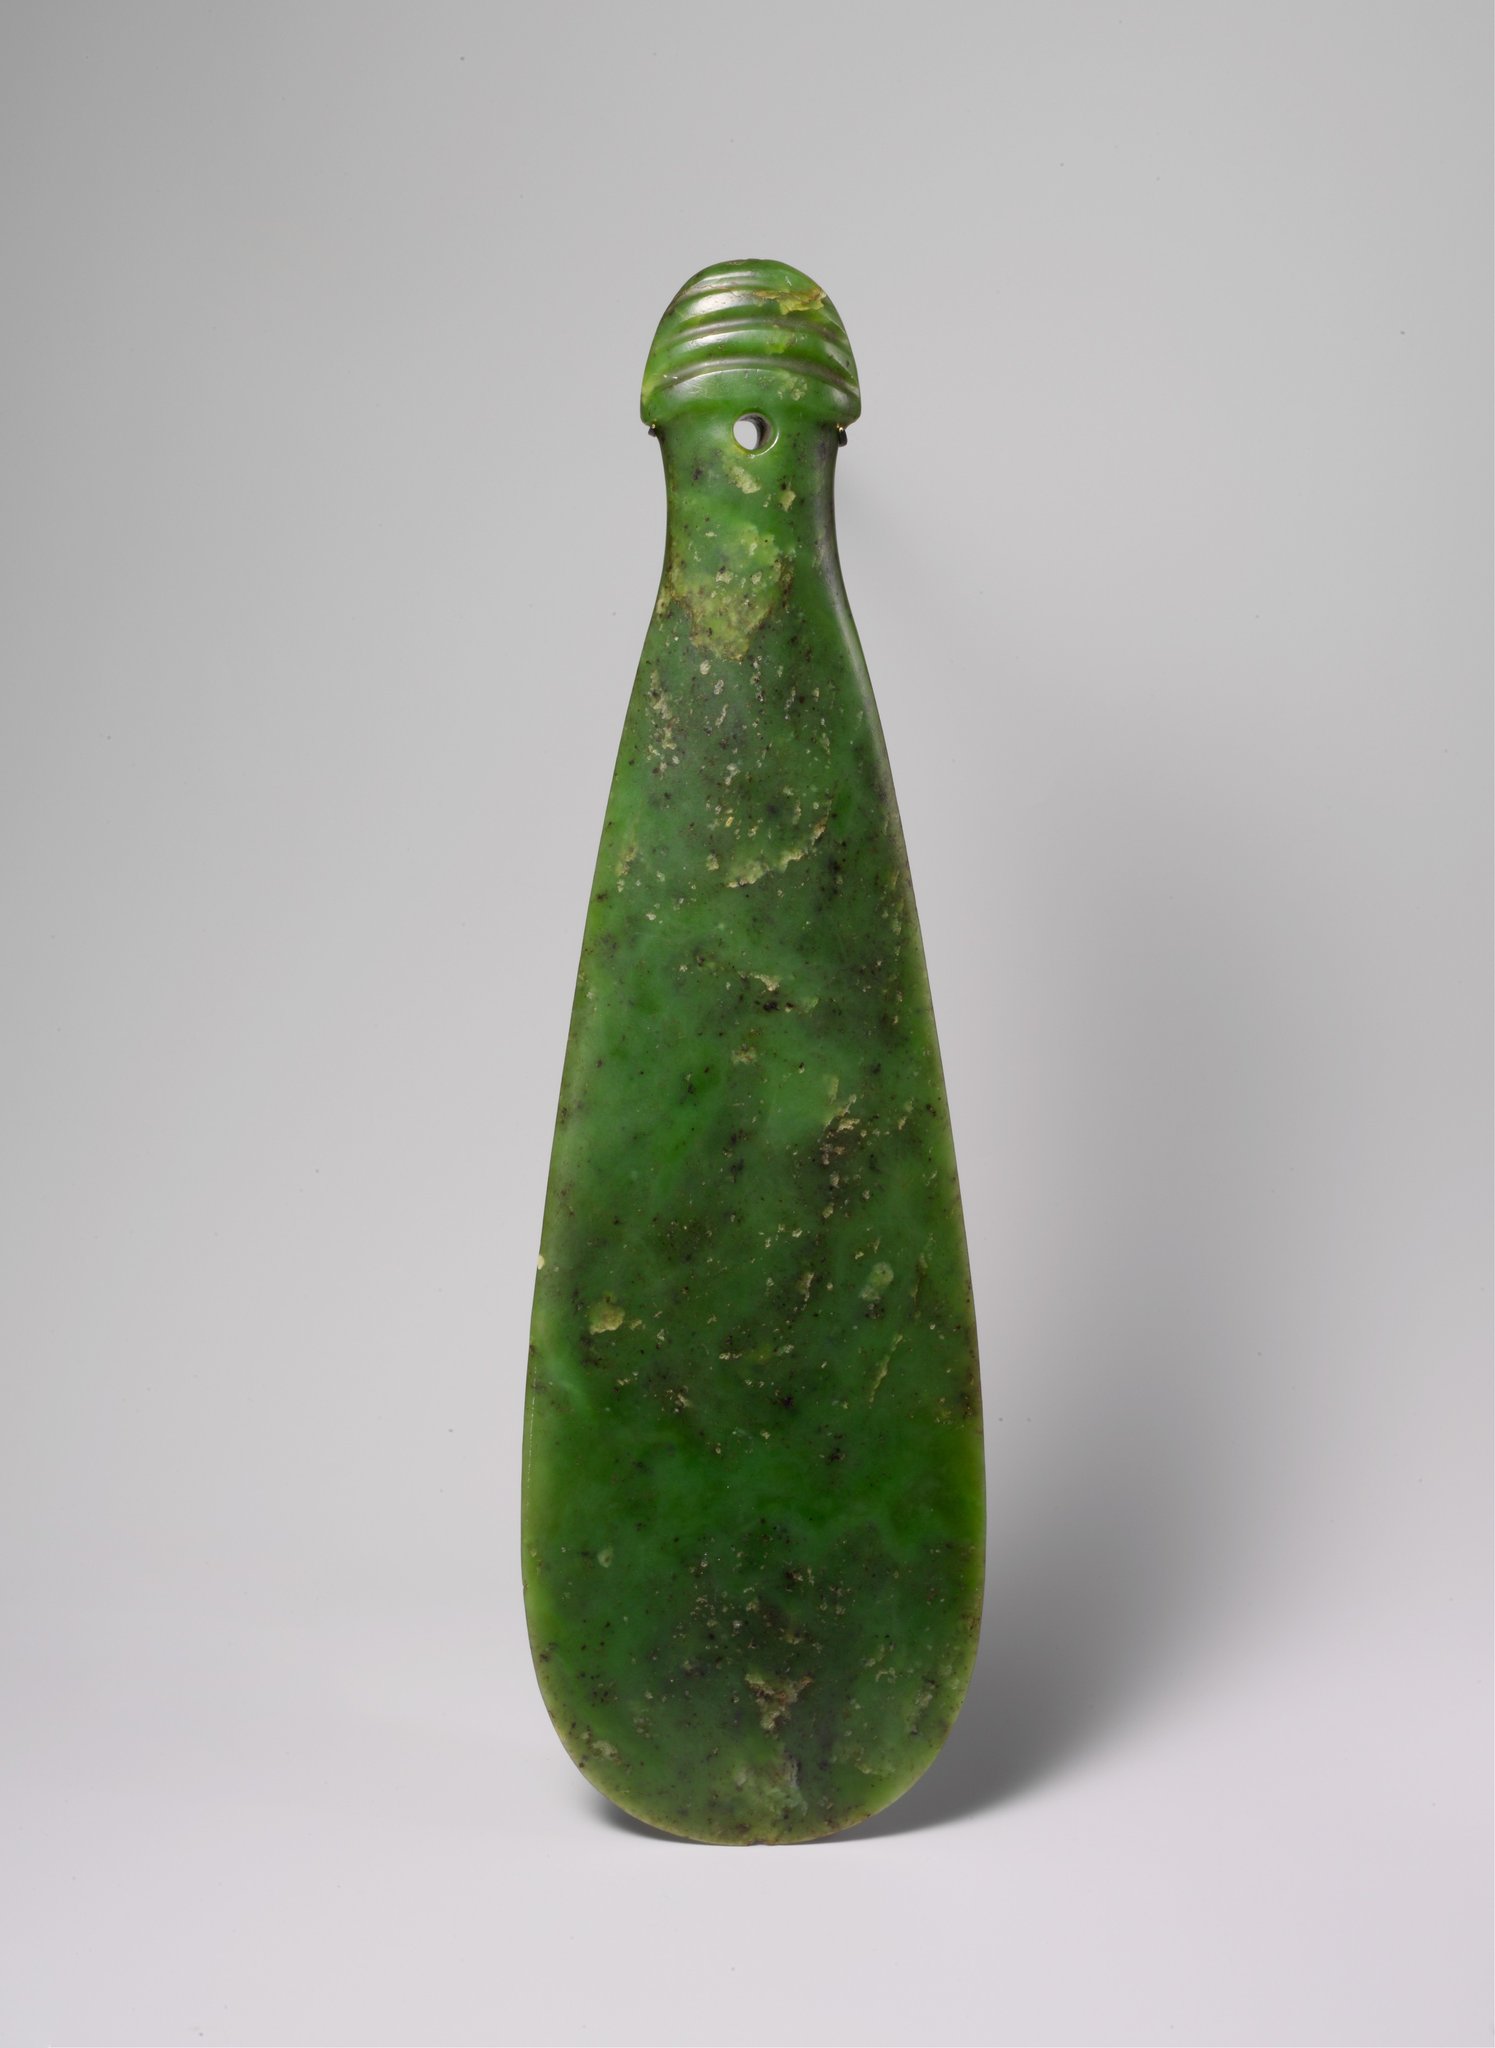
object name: club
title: Hand club (Mere pounamu)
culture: maori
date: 1801-1900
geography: new zealand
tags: weapons